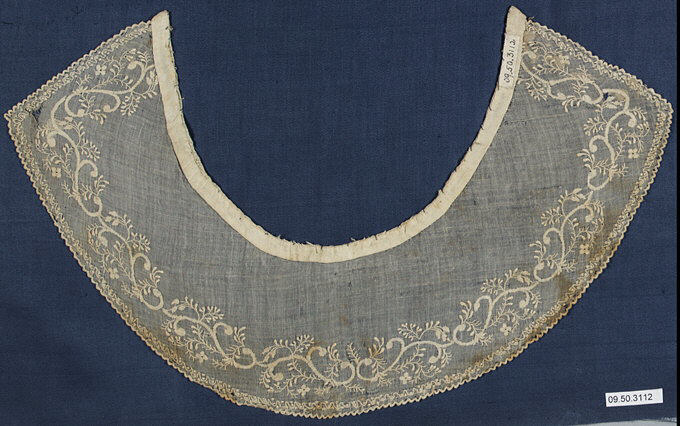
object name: collar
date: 1801-1900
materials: cotton